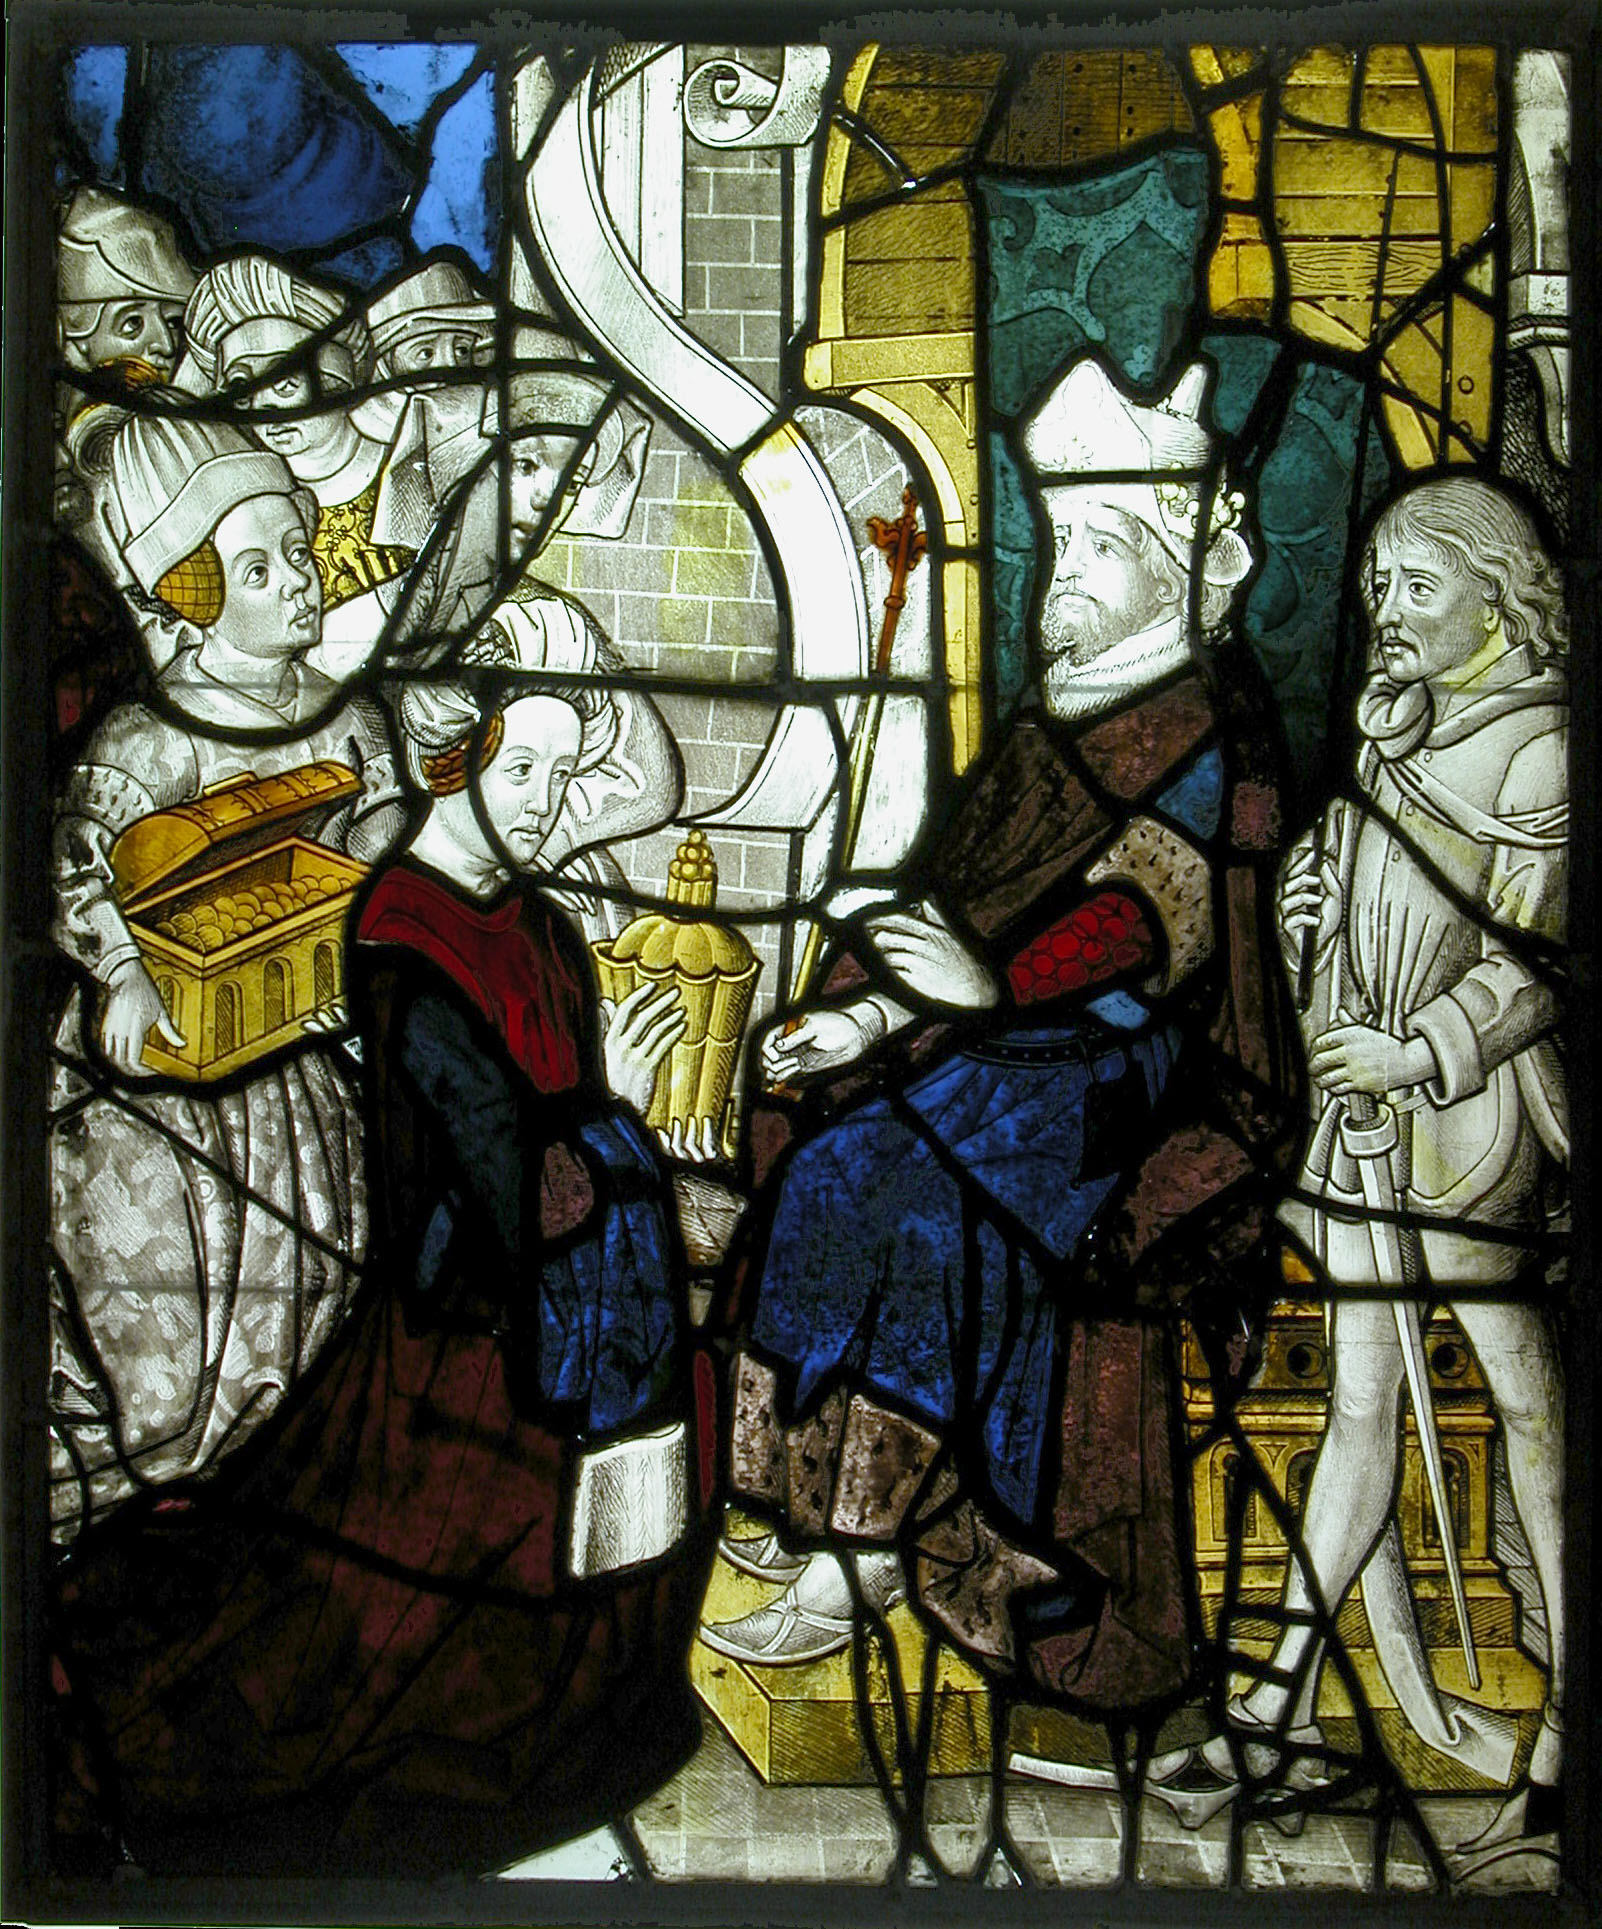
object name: panel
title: Glass Panel with Solomon Receiving The Queen of Sheba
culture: franco-netherlandish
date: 1401-1600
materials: glass, lead, metal, paint, pigment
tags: queens,coins